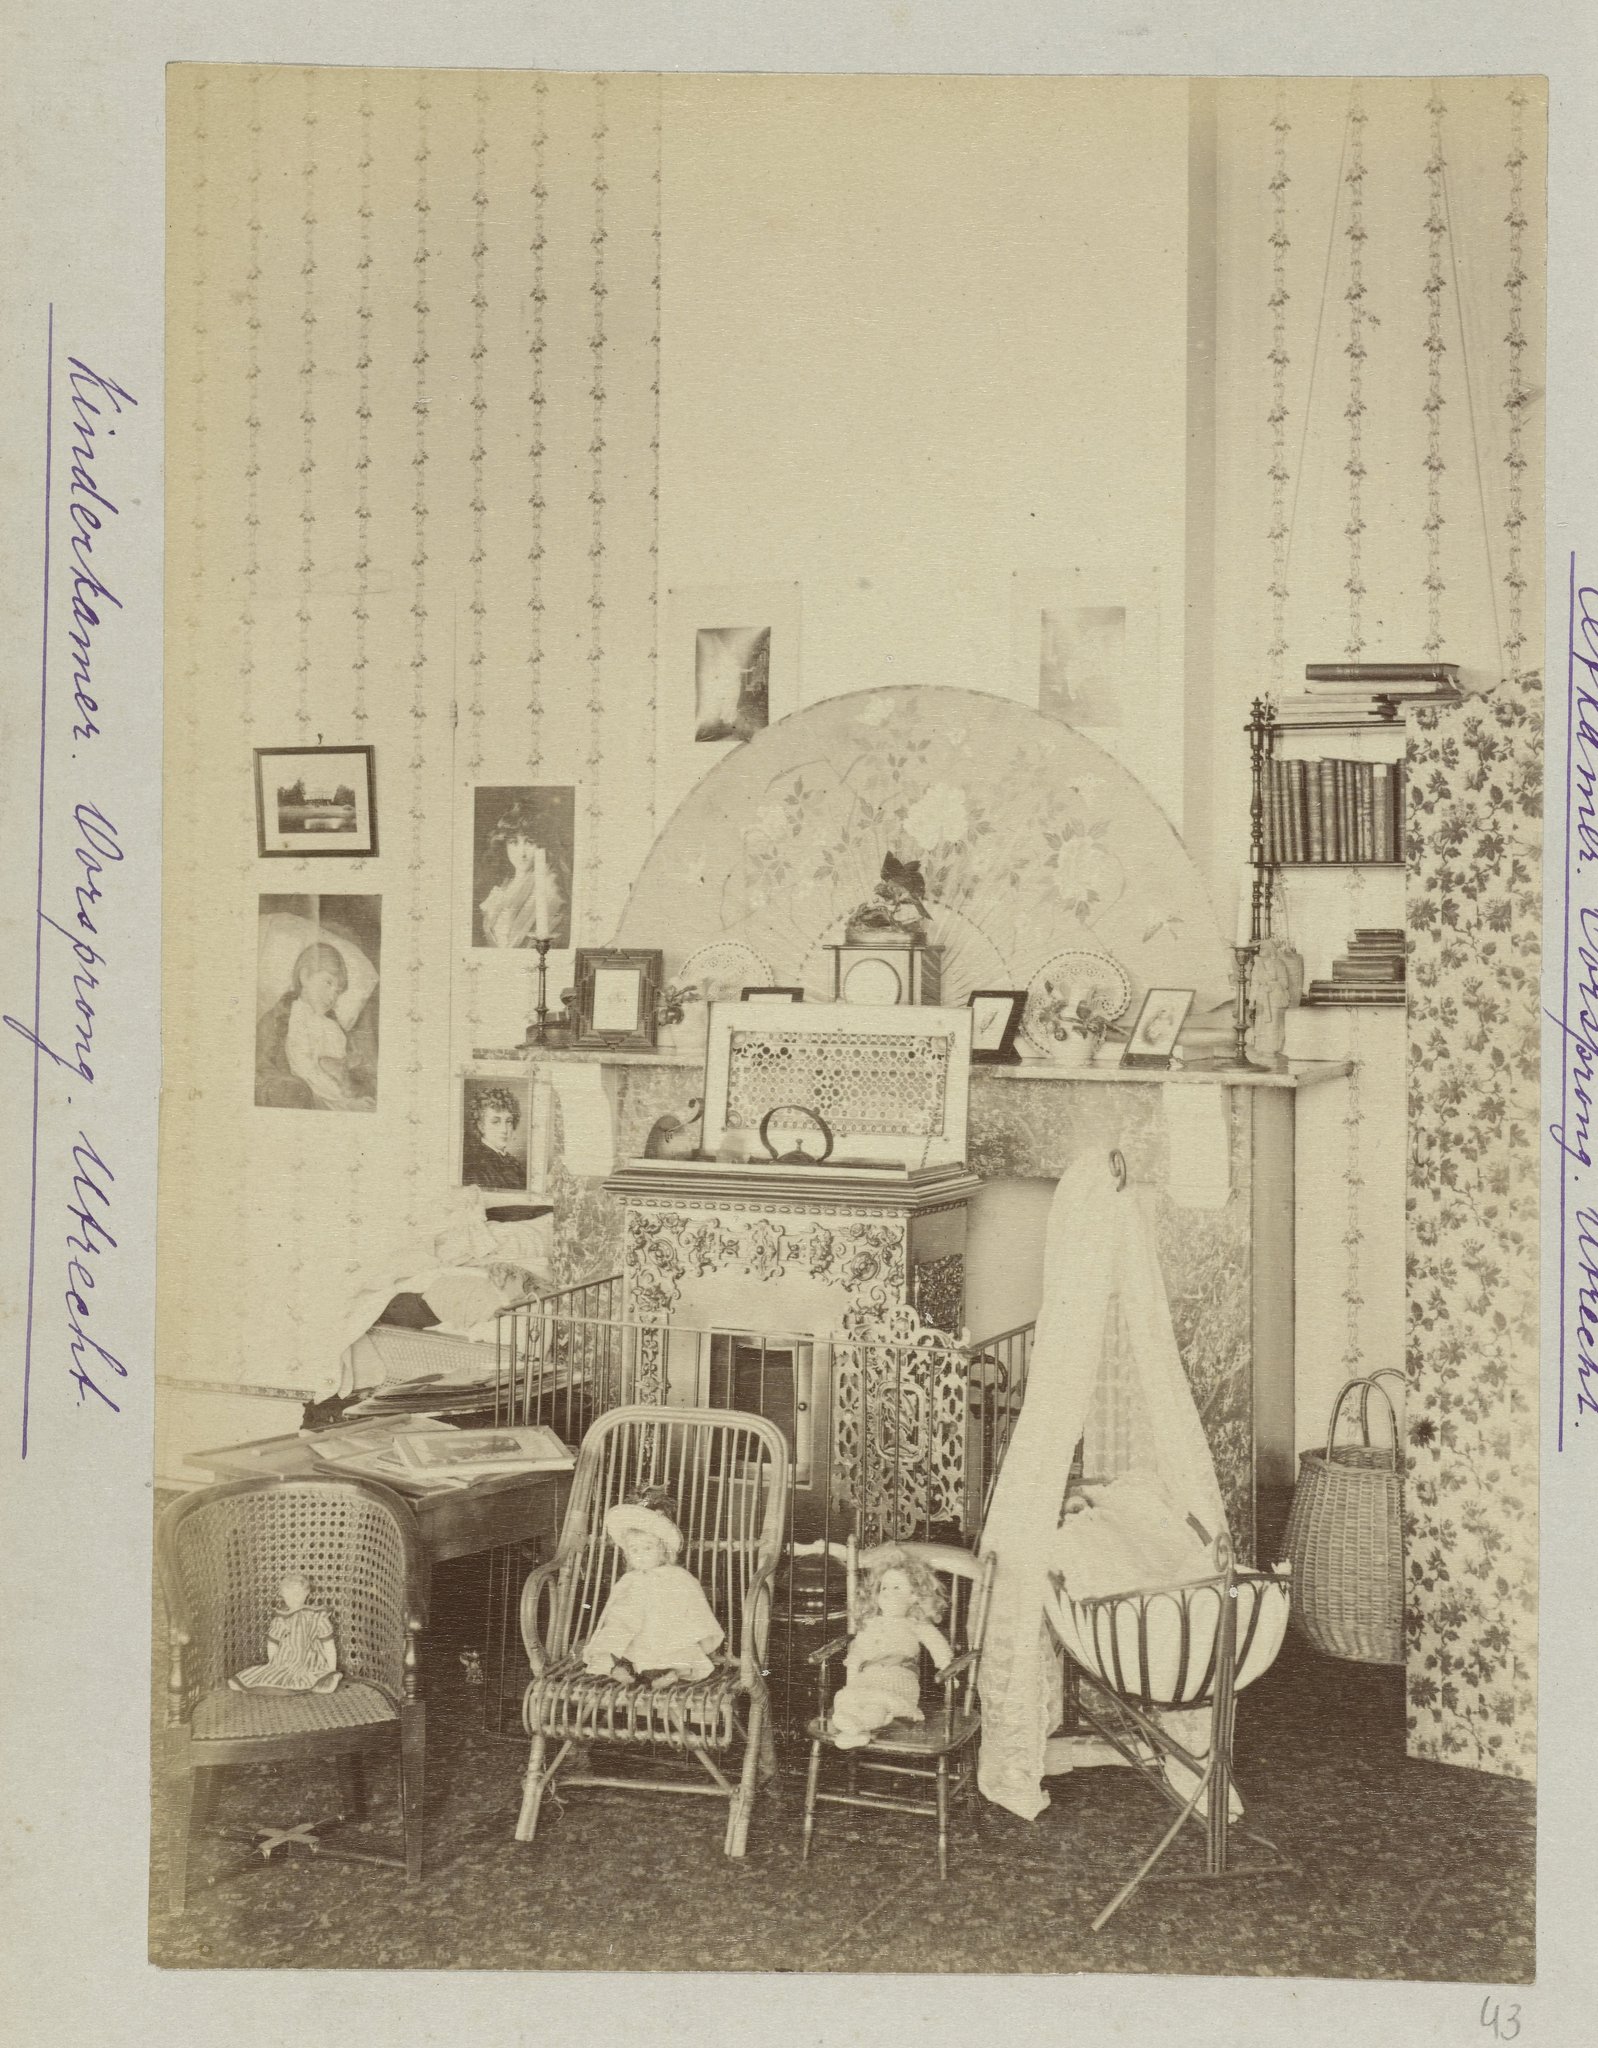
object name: photograph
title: Kinderkamer in herenhuis De Oorsprong in Utrecht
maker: henry pauw van wieldrecht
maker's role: fotograaf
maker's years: 1863-1912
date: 1889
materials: paper, photographic support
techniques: albumen print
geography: netherlands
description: Een kamer met poppen en kinderstoelen in herenhuis De Oorsprong in Utrecht. Links op het albumblad geschreven: Kinderkamer Oorsprong Utrecht.